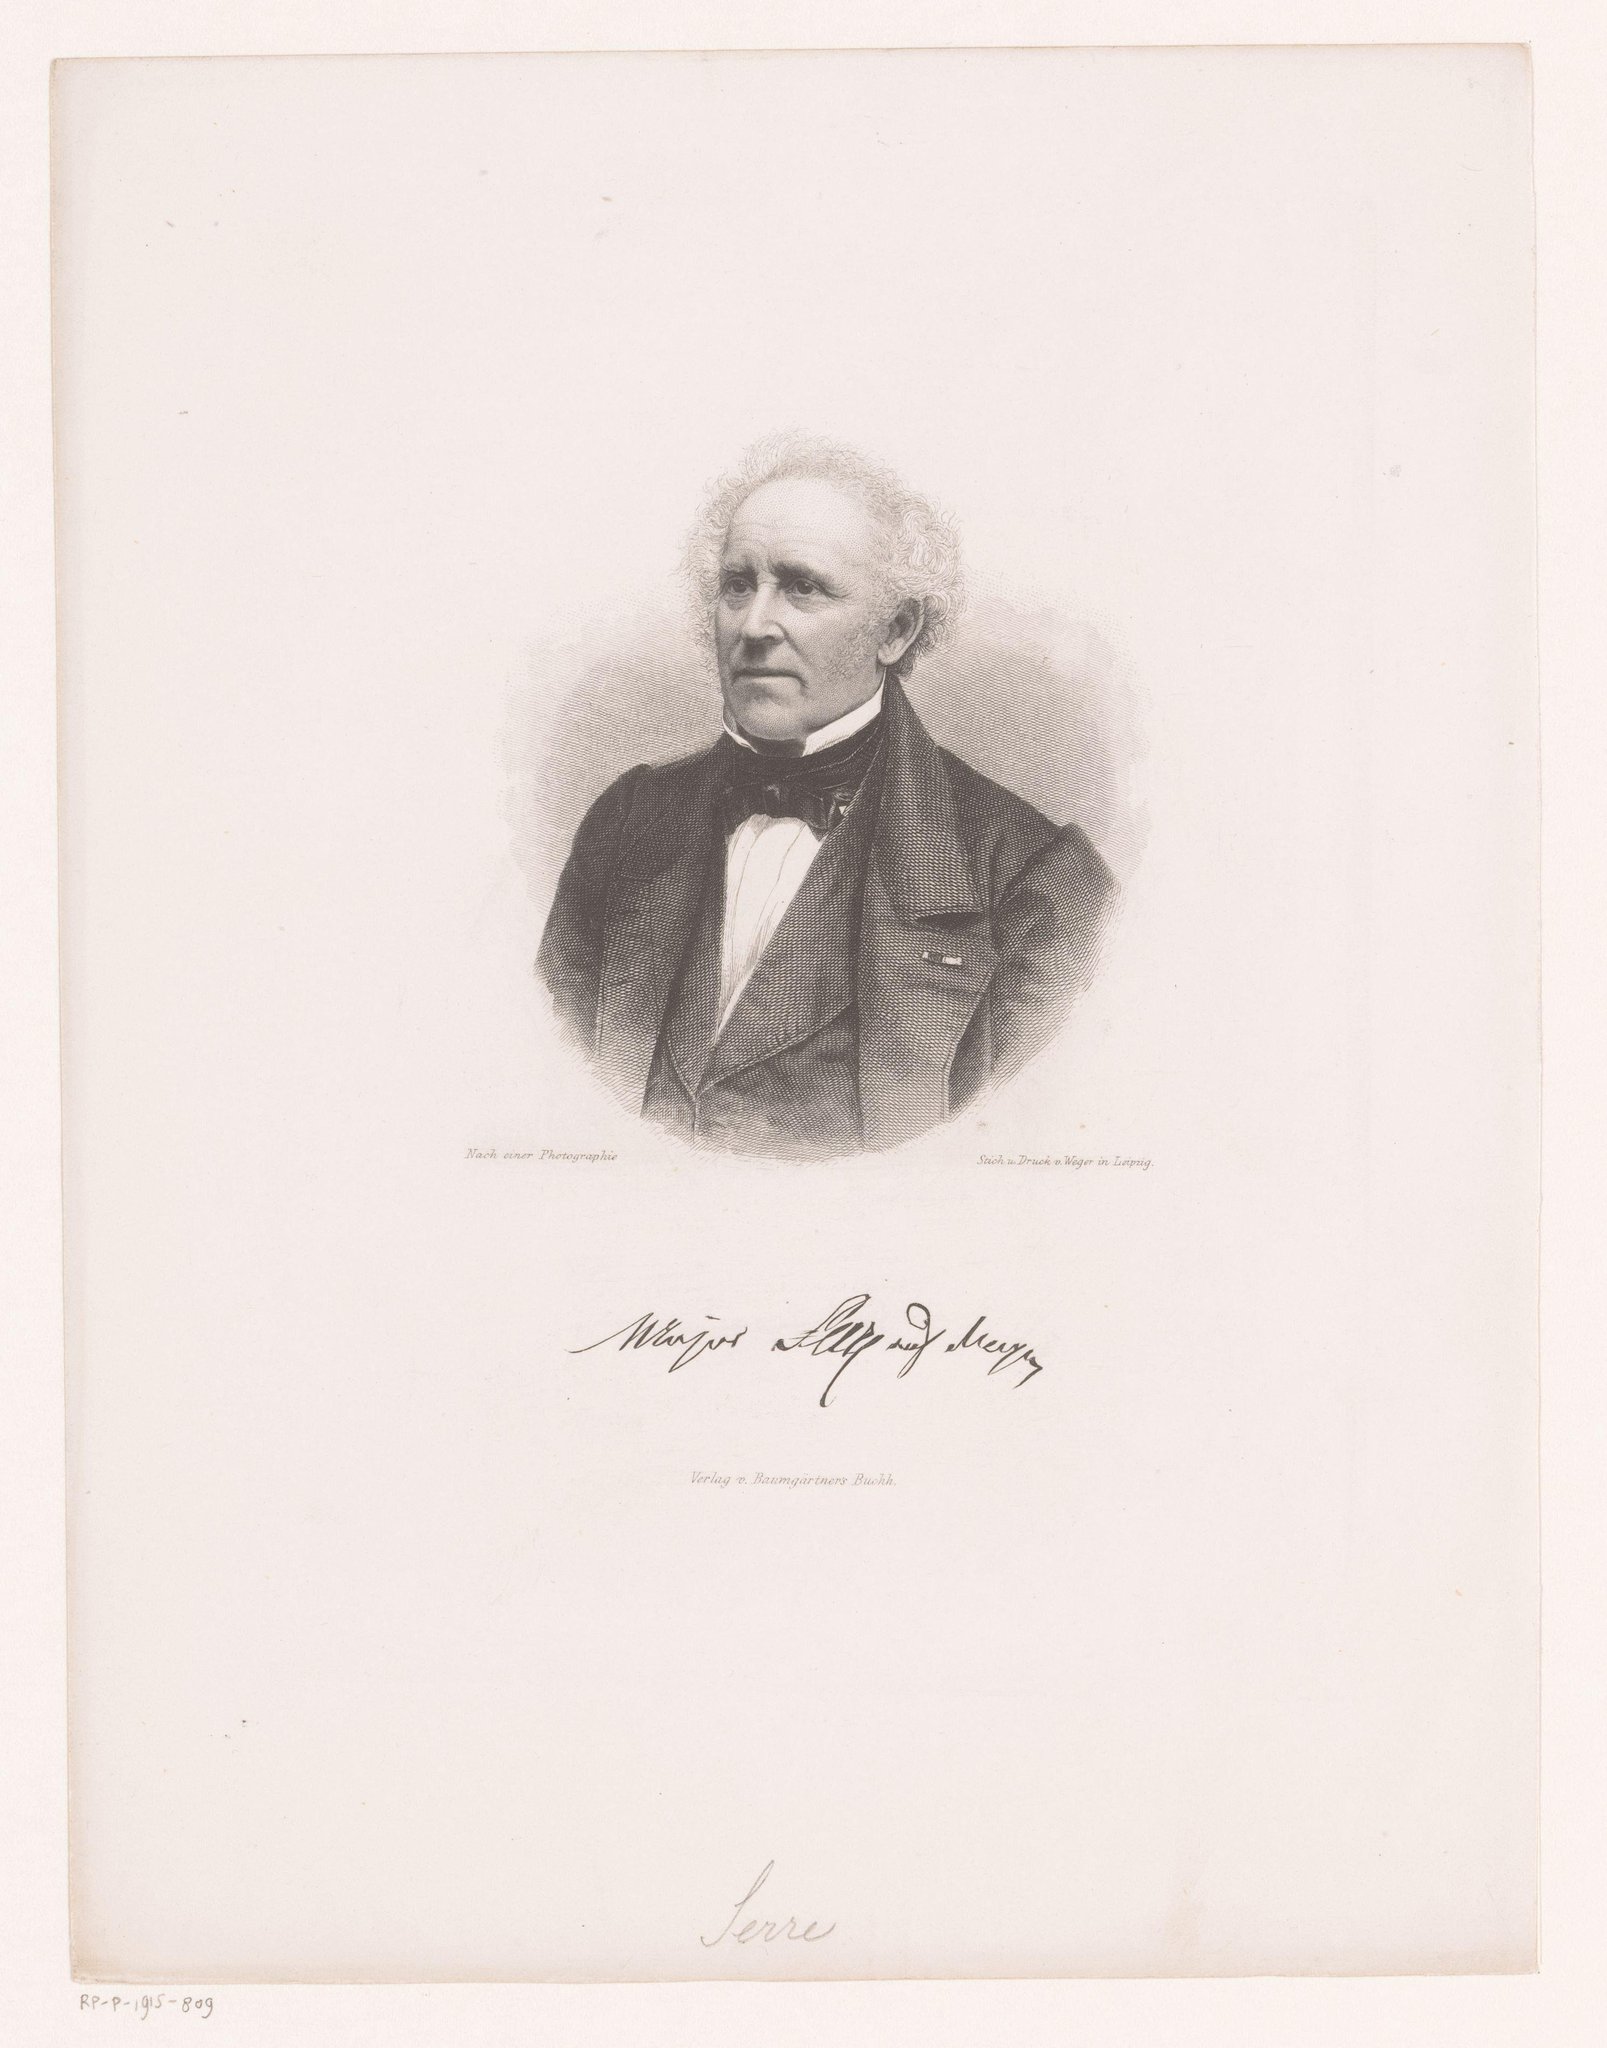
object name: print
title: Portret van Friedrich Serre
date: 1840-1892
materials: paper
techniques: engraving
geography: leipzig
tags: historical persons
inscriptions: collector's mark: Lugt 2228